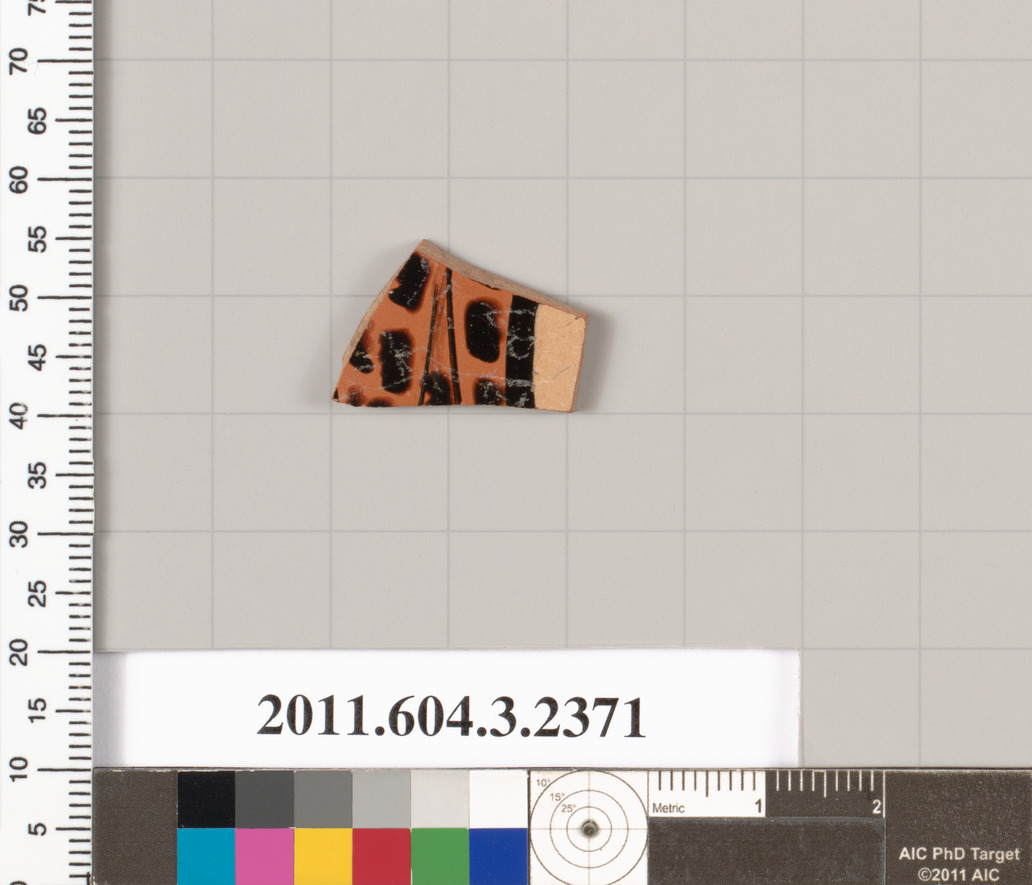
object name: kylix fragment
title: Terracotta fragment of a kylix: eye-cup (drinking cup)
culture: greek, attic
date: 540-520 BCE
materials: terracotta